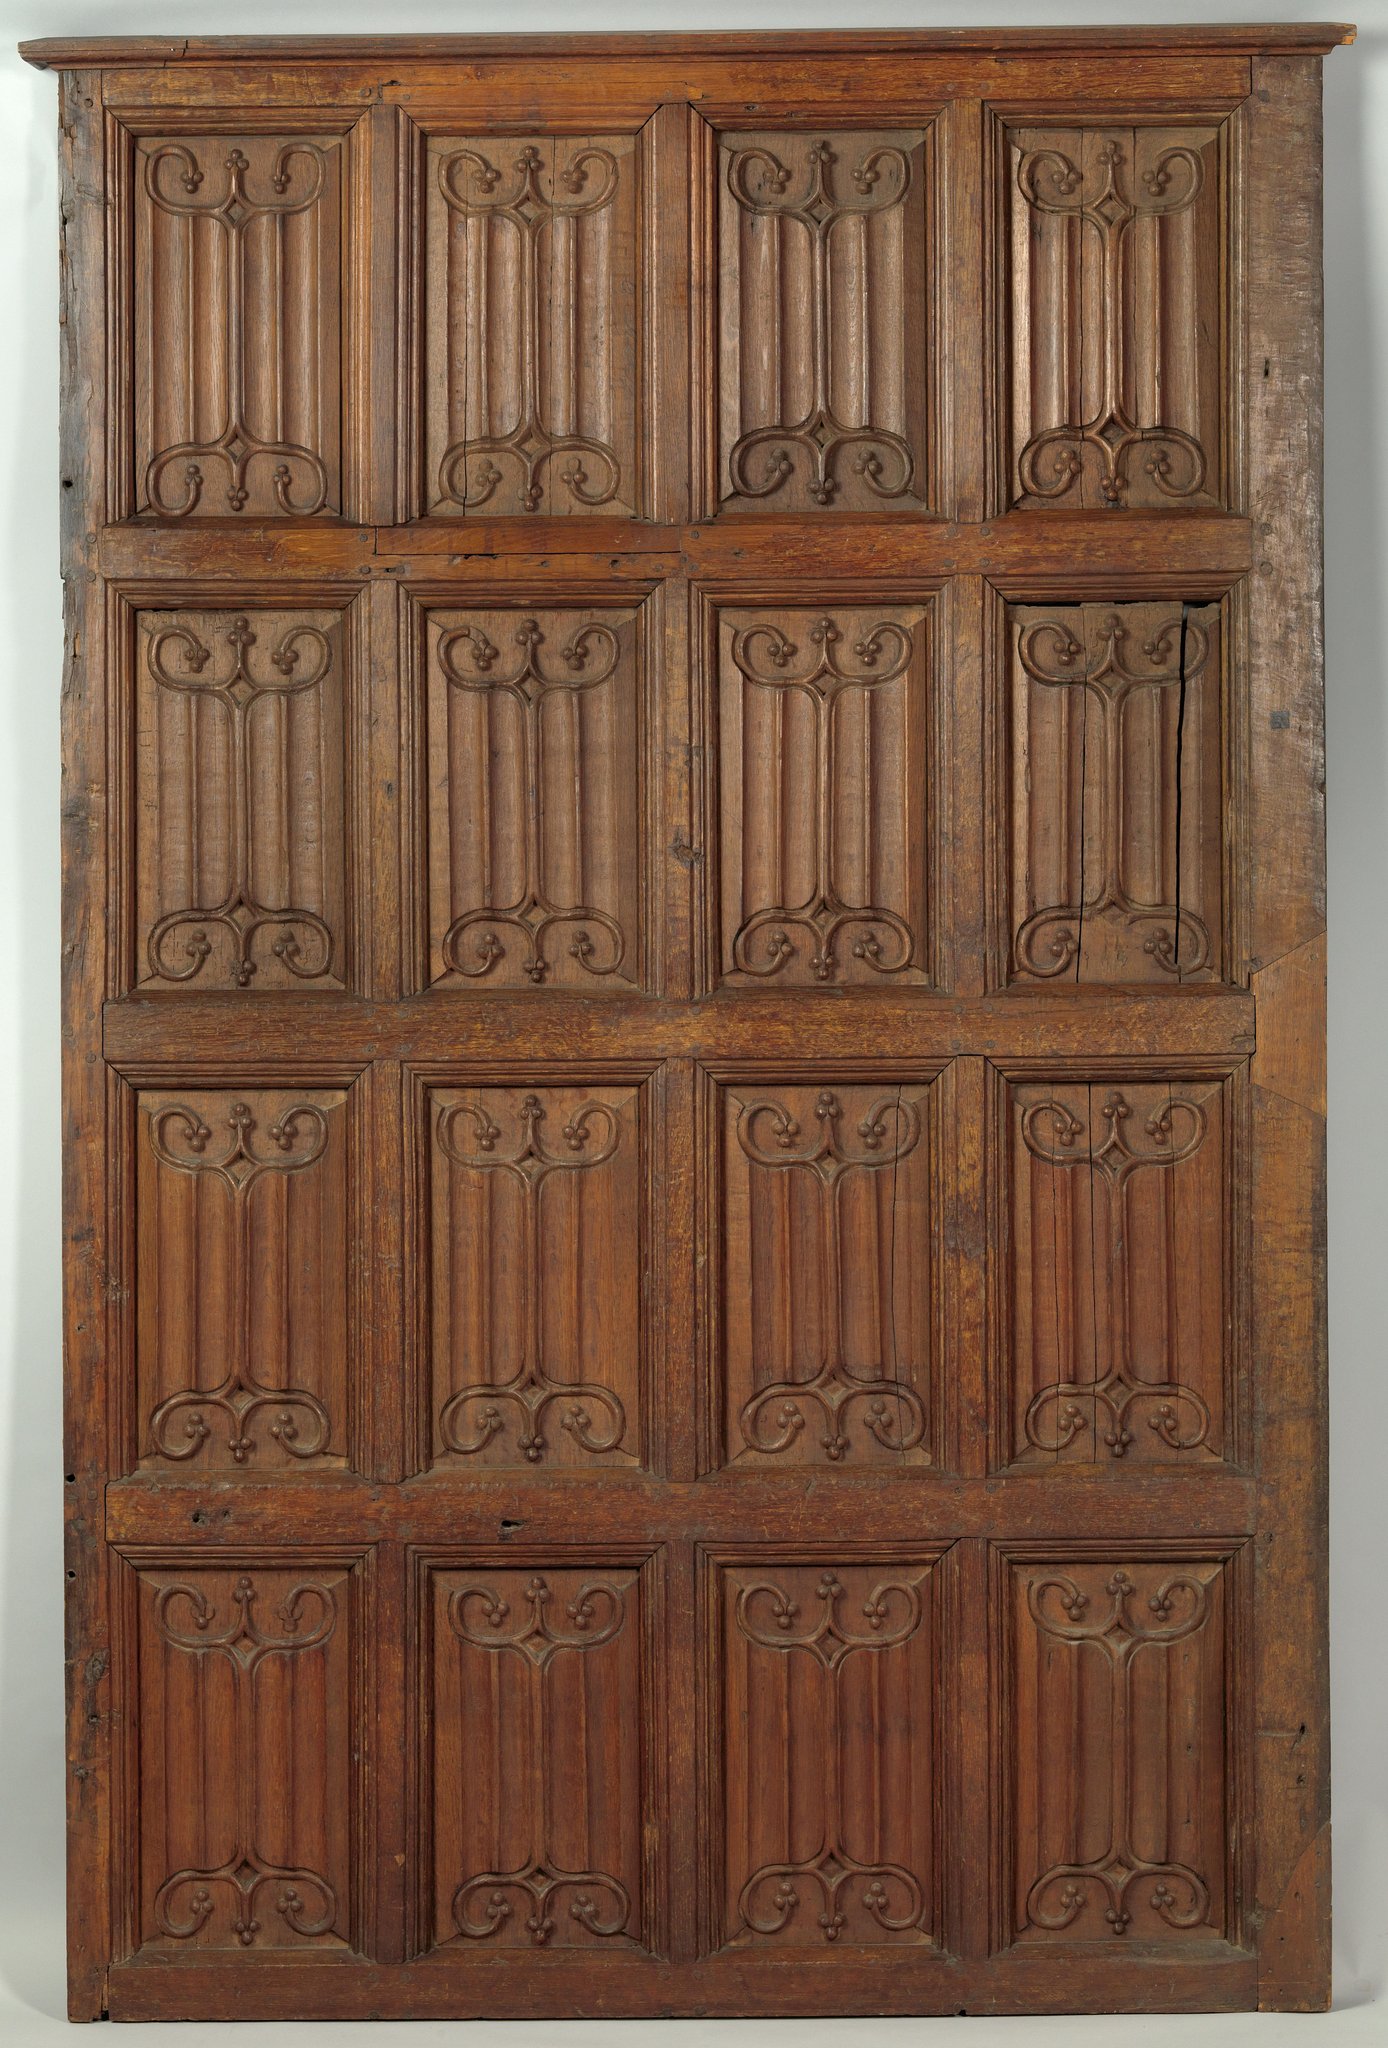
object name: architectural element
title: Betimmering met panelen die met de "brief" met uitgroeiende hoekvoluten zijn versierd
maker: Anonymous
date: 1500-1550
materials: wood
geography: netherlands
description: Betimmering van eikenhout, gedeeld in vier schotten, die door drie stijlen en drie regels in zestien rechthoekige panelen worden verdeeld. De panelen zijn versierd met de "brief" met uitgroeiende hoekvoluten, ieder eindigend in drie bolletjes in de uitgrondingen.